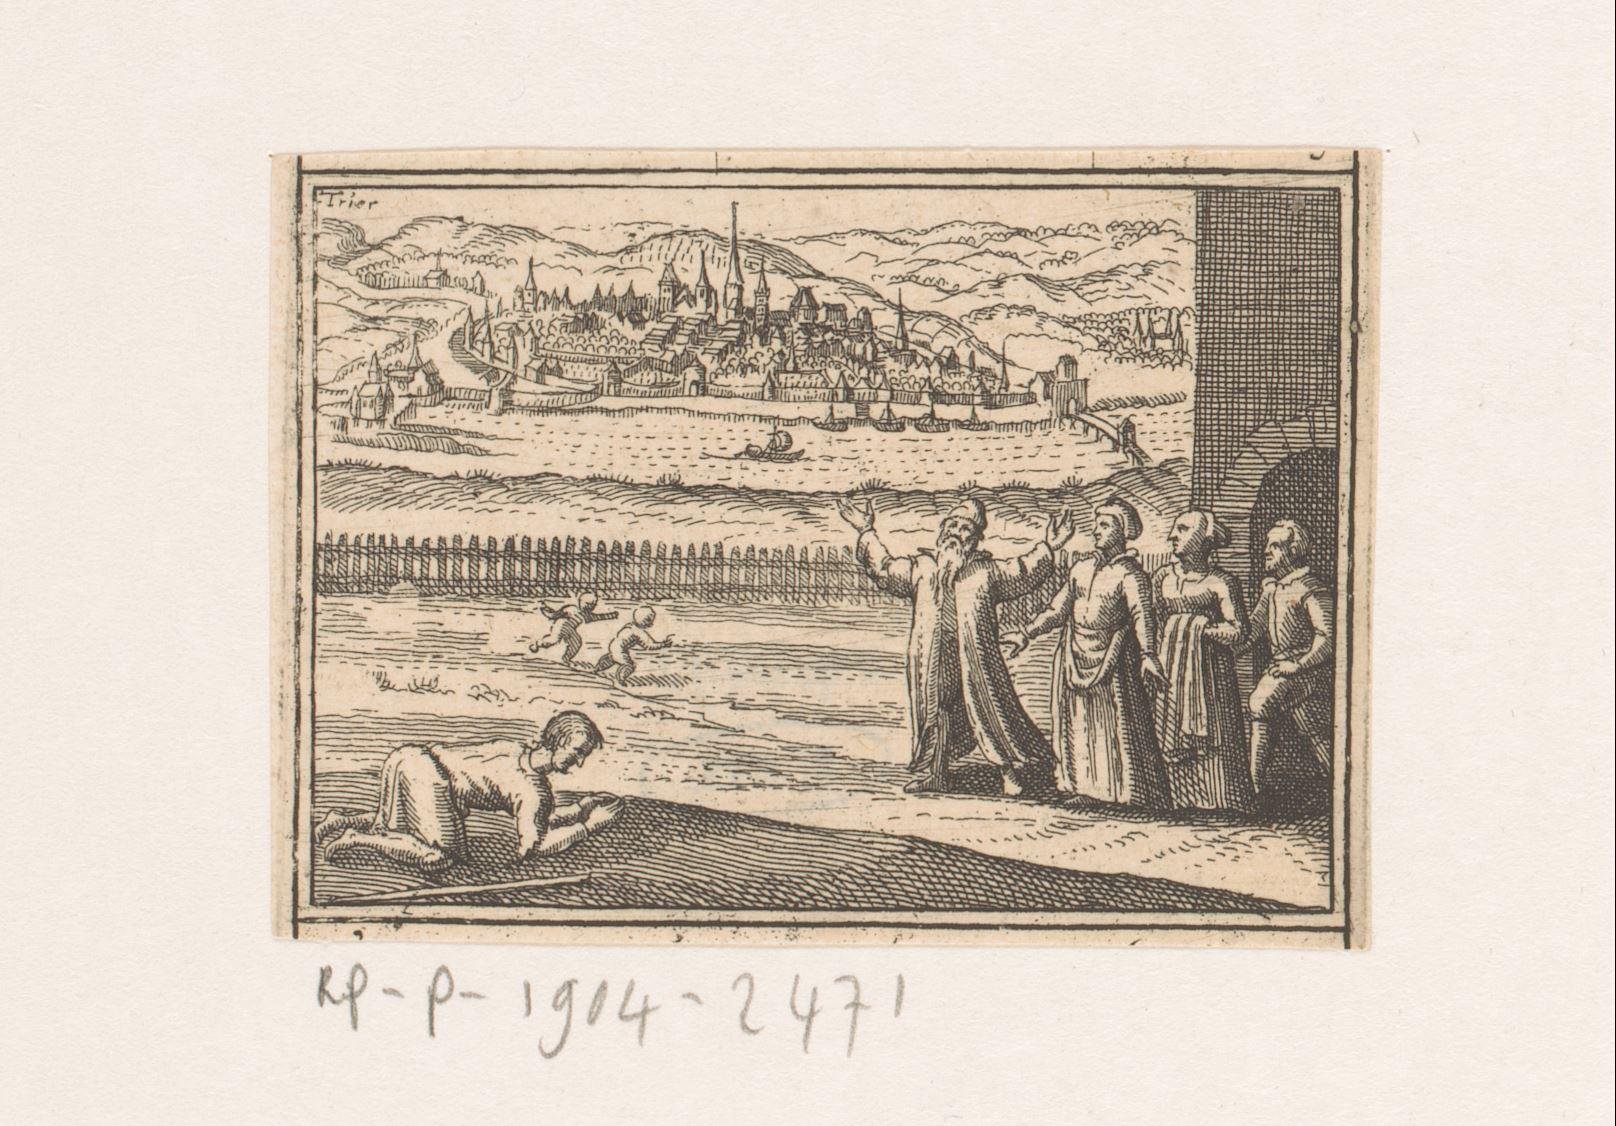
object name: book illustration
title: Trier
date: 1624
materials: paper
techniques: engraving, etching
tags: city-view, and landscape with man-made constructions, running (~ game), arm raised, with fingers spread out, kneeling on both knees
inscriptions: collector's mark: Lugt 2228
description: Prent uit: Sudermann, Daniel. Centuria Similitudinum, Hubert Gleichnussen. Straatsburg, Jacob van der Heyden, 1624. (Hollstein German XXVIA 646).